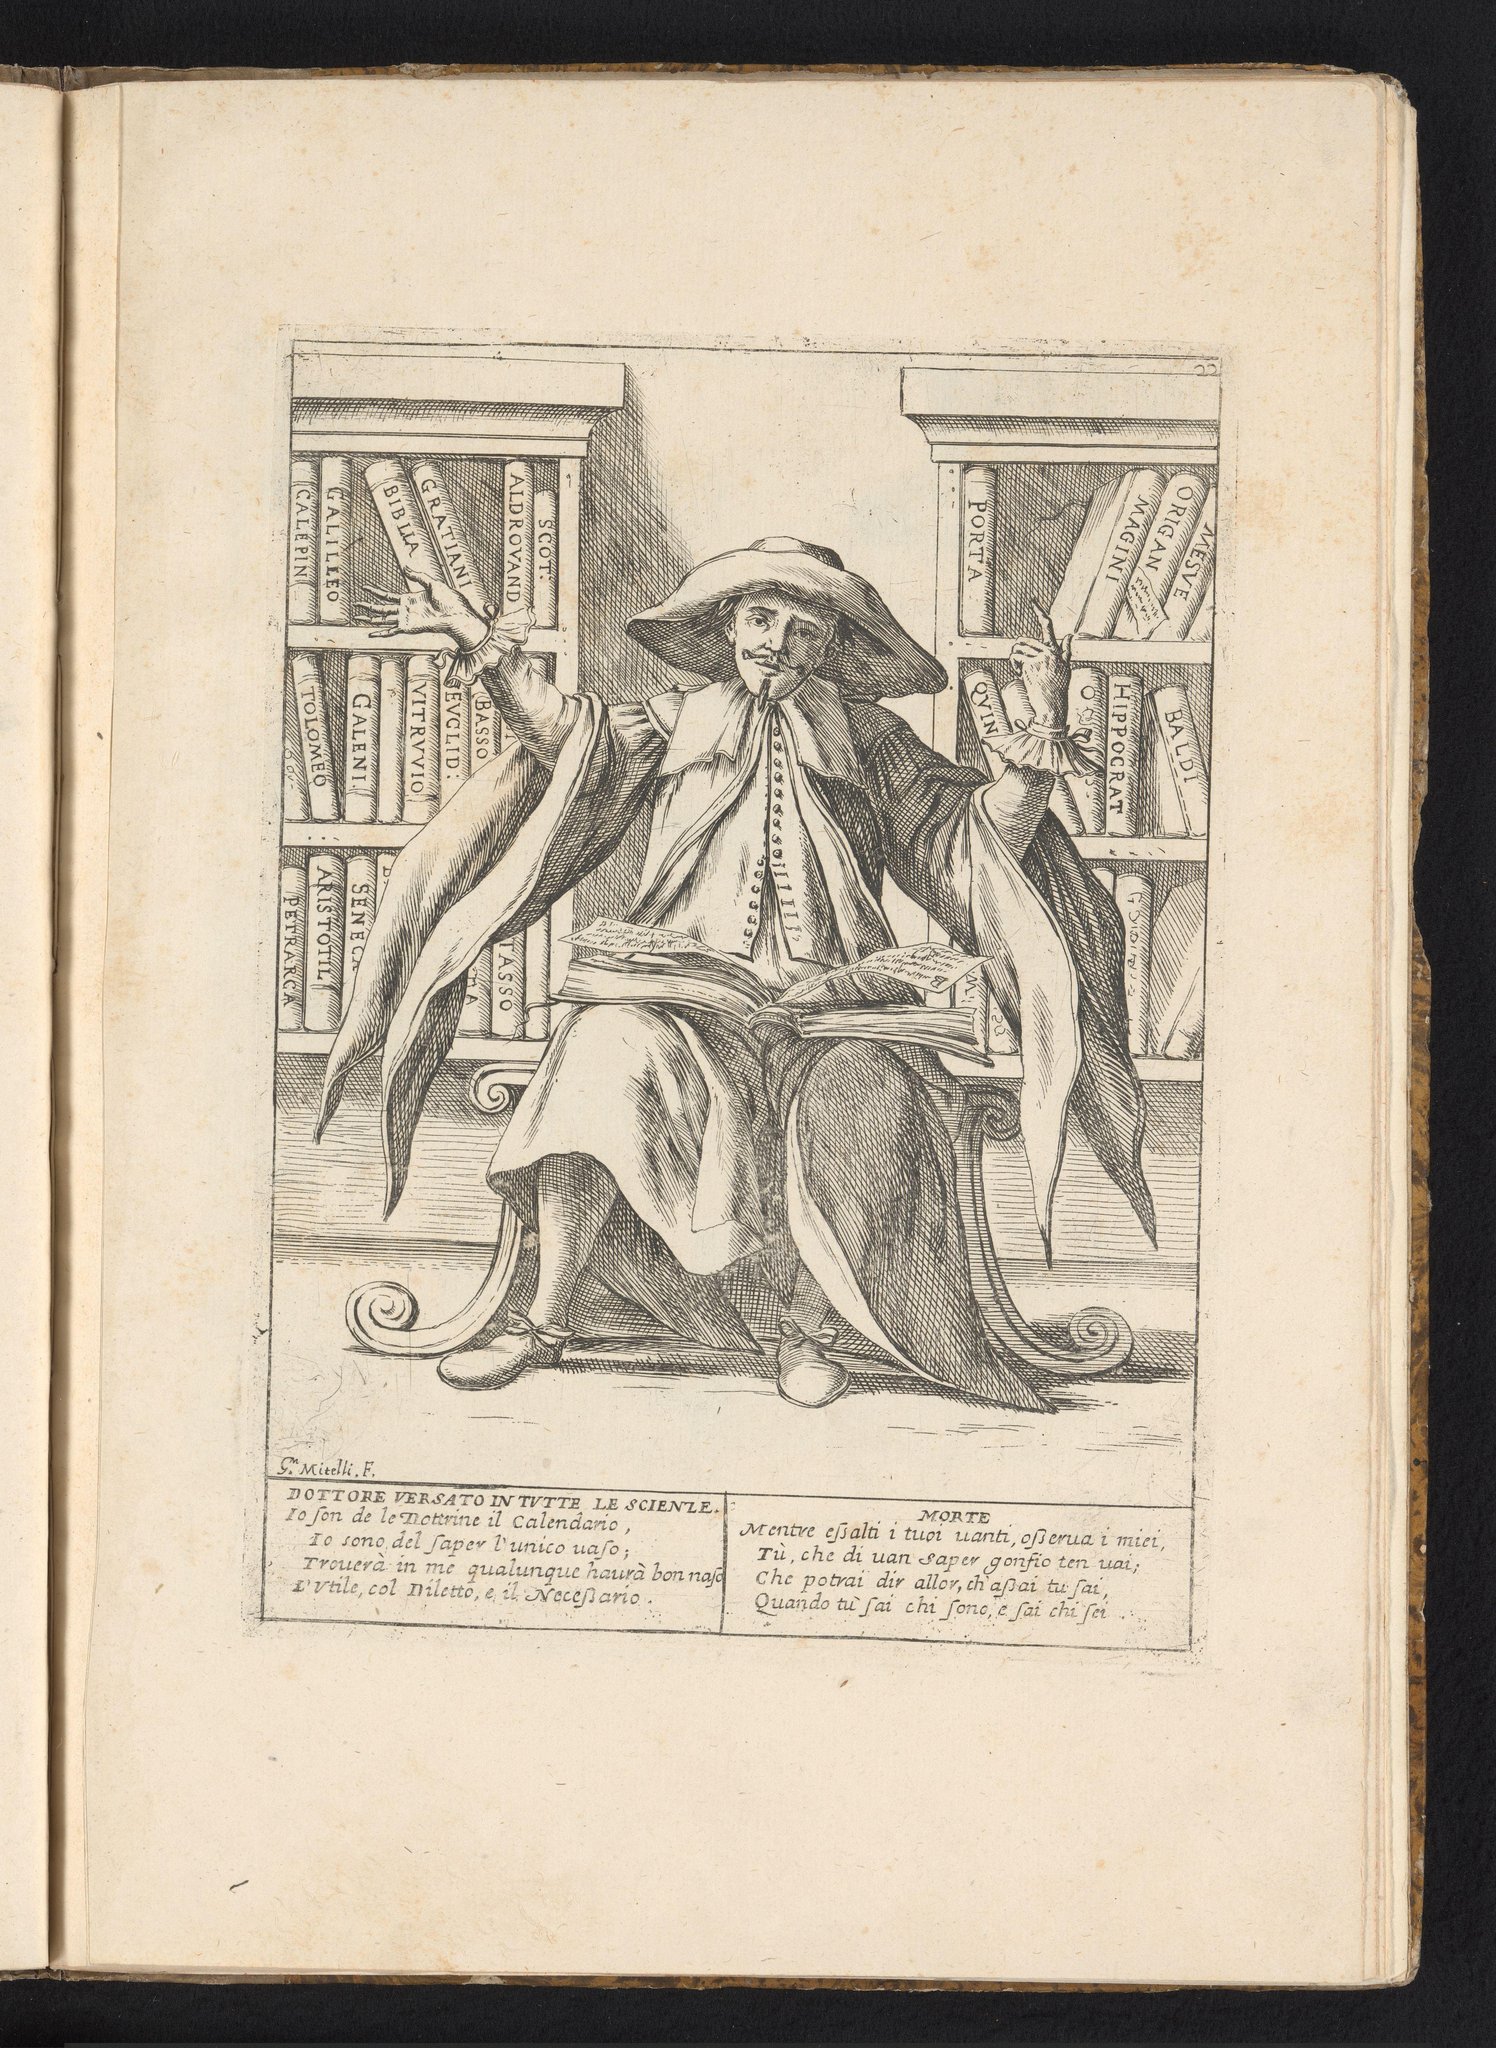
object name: print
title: De allesweter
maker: giuseppe maria mitelli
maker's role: draughtsman, painter, print maker, publisher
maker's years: 1634-1718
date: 1675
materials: paper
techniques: engraving, etching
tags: scholar in his study, scenes symbolizing 'vanitas', the 24 hours of day and night, book, personifications ~ the life of man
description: Een wetenschapper die alles weet (Dottore Versato). Man zittend in een studeerkamer omringd door boekenkasten met boeken. Met twee vierregelige verzen in het Italiaans. Genummerd rechtsboven: 22. Onderdeel van de serie 'De vierentwintig uren van het menselijk geluk'.